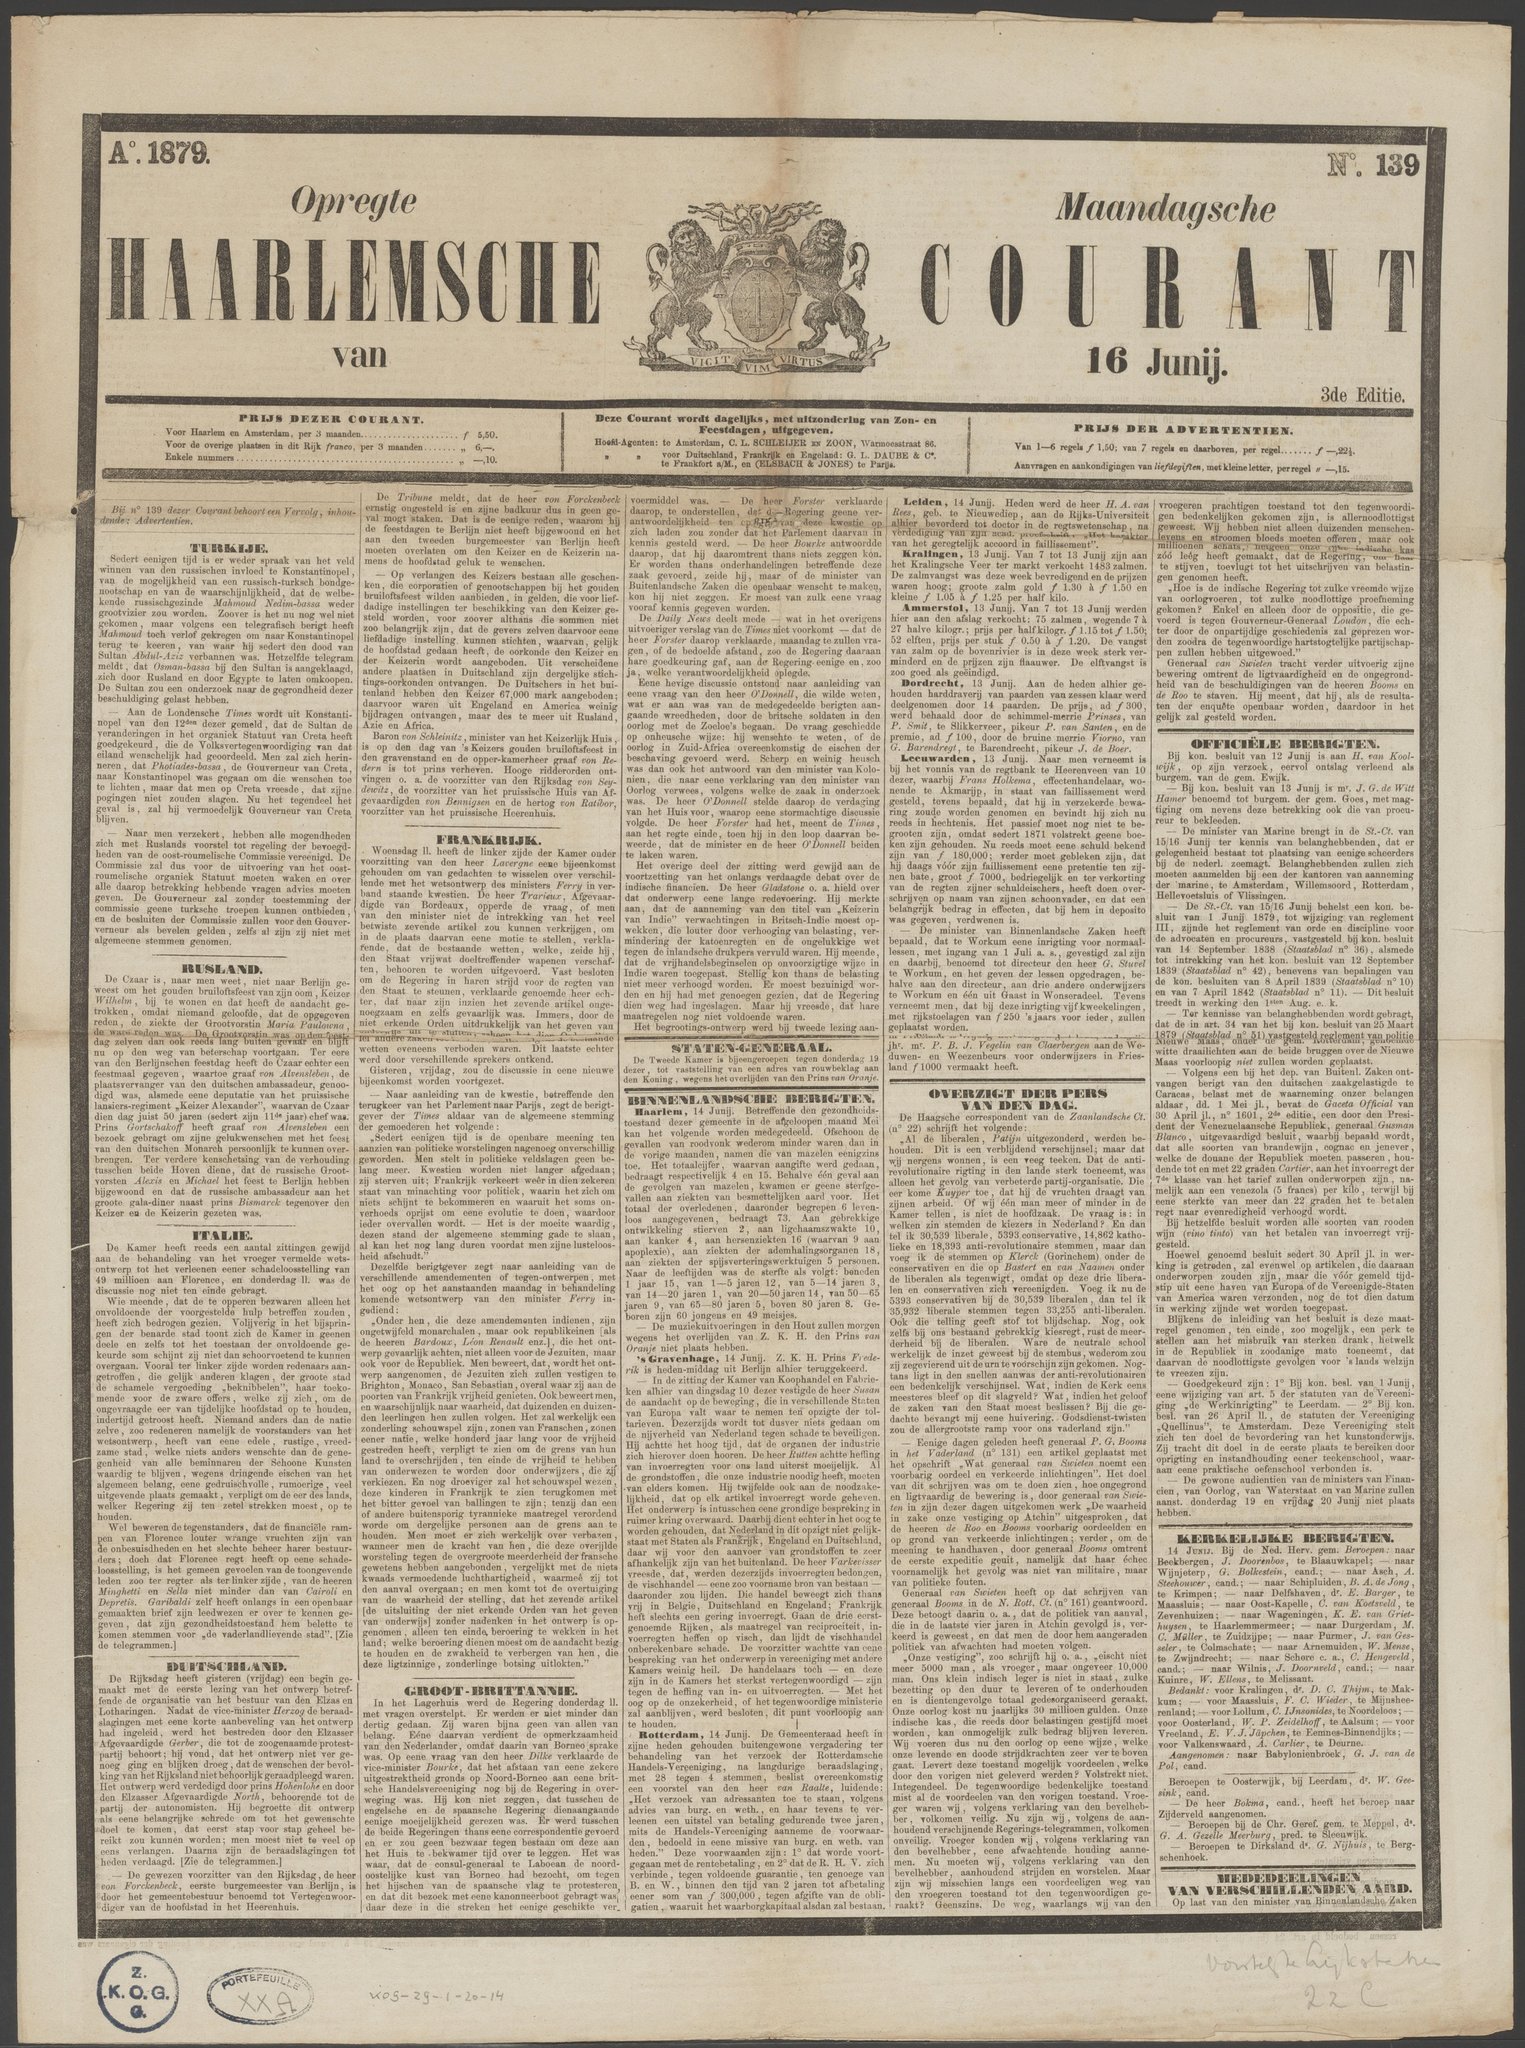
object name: text sheet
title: Opregte Maandagsche Haarlemsche Courant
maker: Anonymous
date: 1879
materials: paper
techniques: letterpress printing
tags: hendrik (prins der nederlanden), burial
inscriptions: collector's mark: Lugt 1641, stamp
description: Rechtsboven genummerd: No. 139. Onderwerpsrubrieken binnen de Atlas Zeden en Gewoonten: Zeden en Gewoonten in Engeren Zin, Des menschen beging, midden en einde, Vorstelijke lijkstaties.